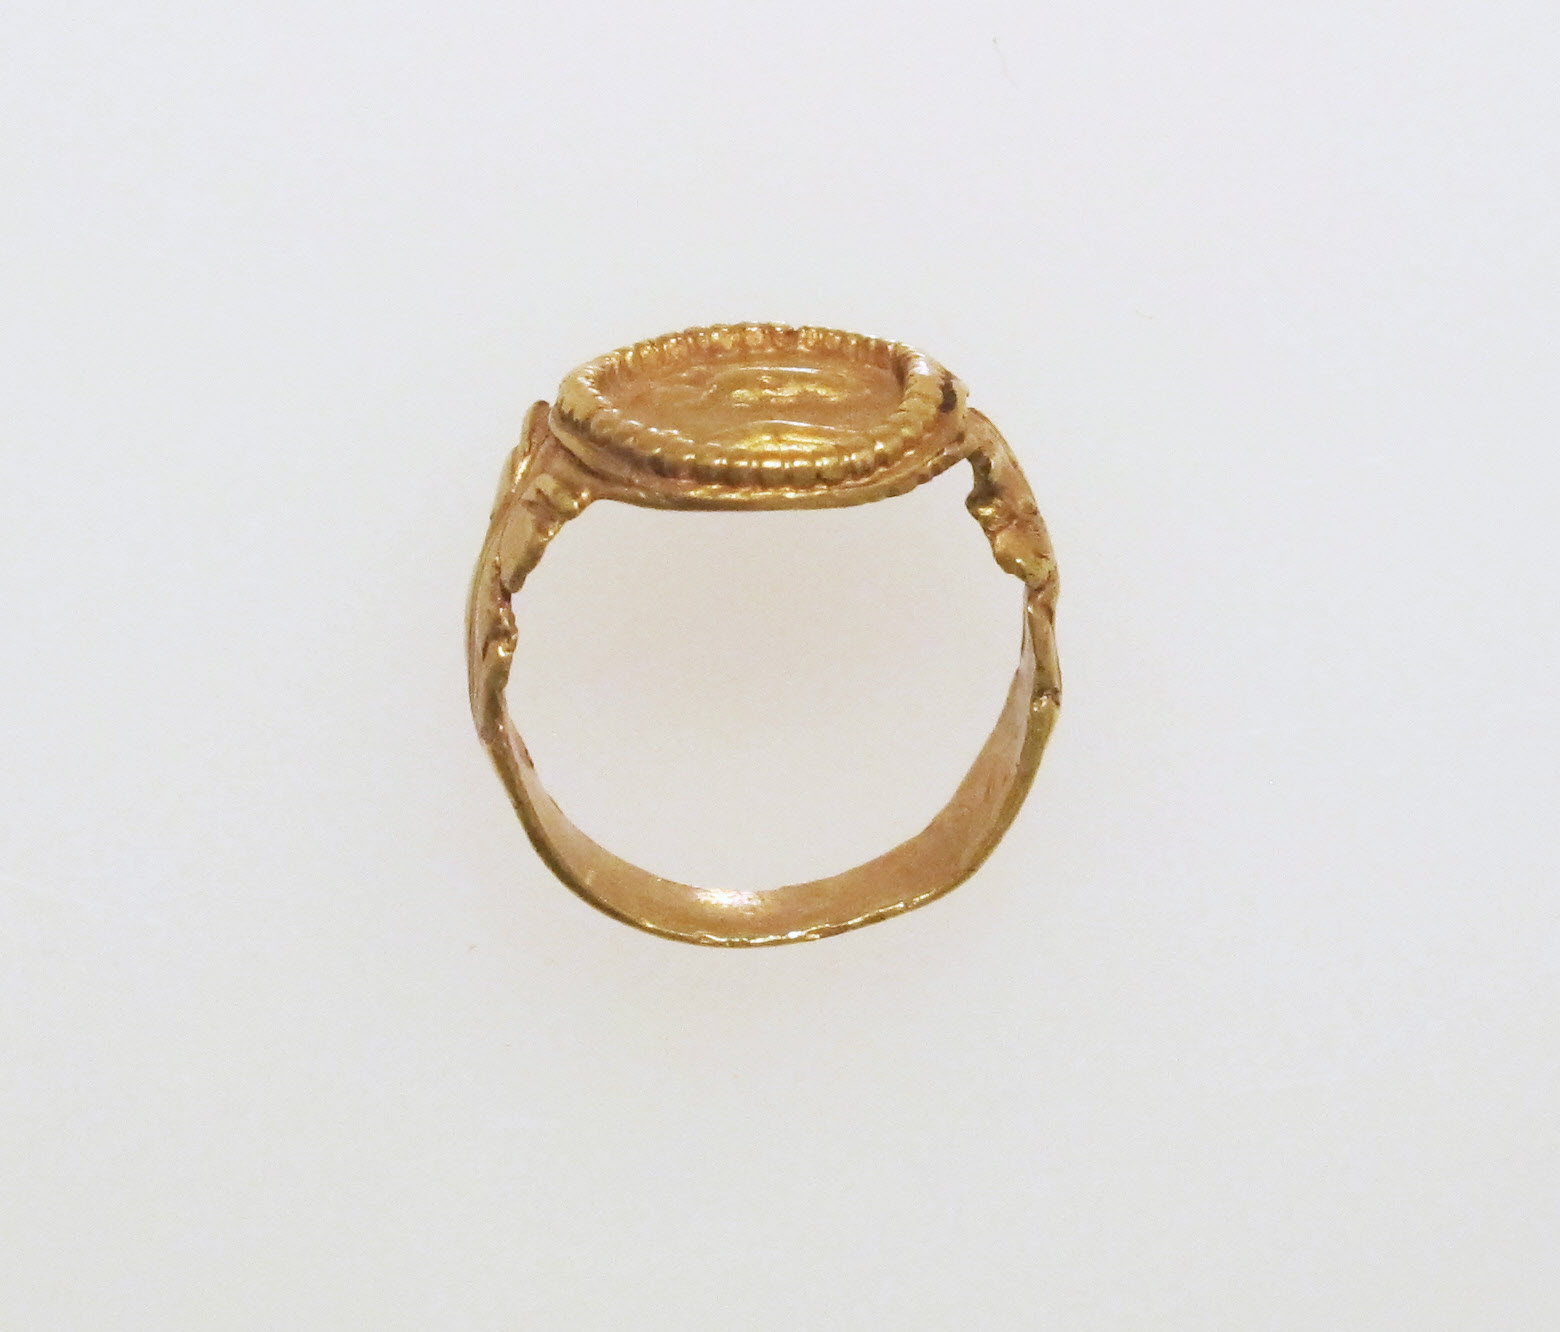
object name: earring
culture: roman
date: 670 BCE-330 CE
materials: gold